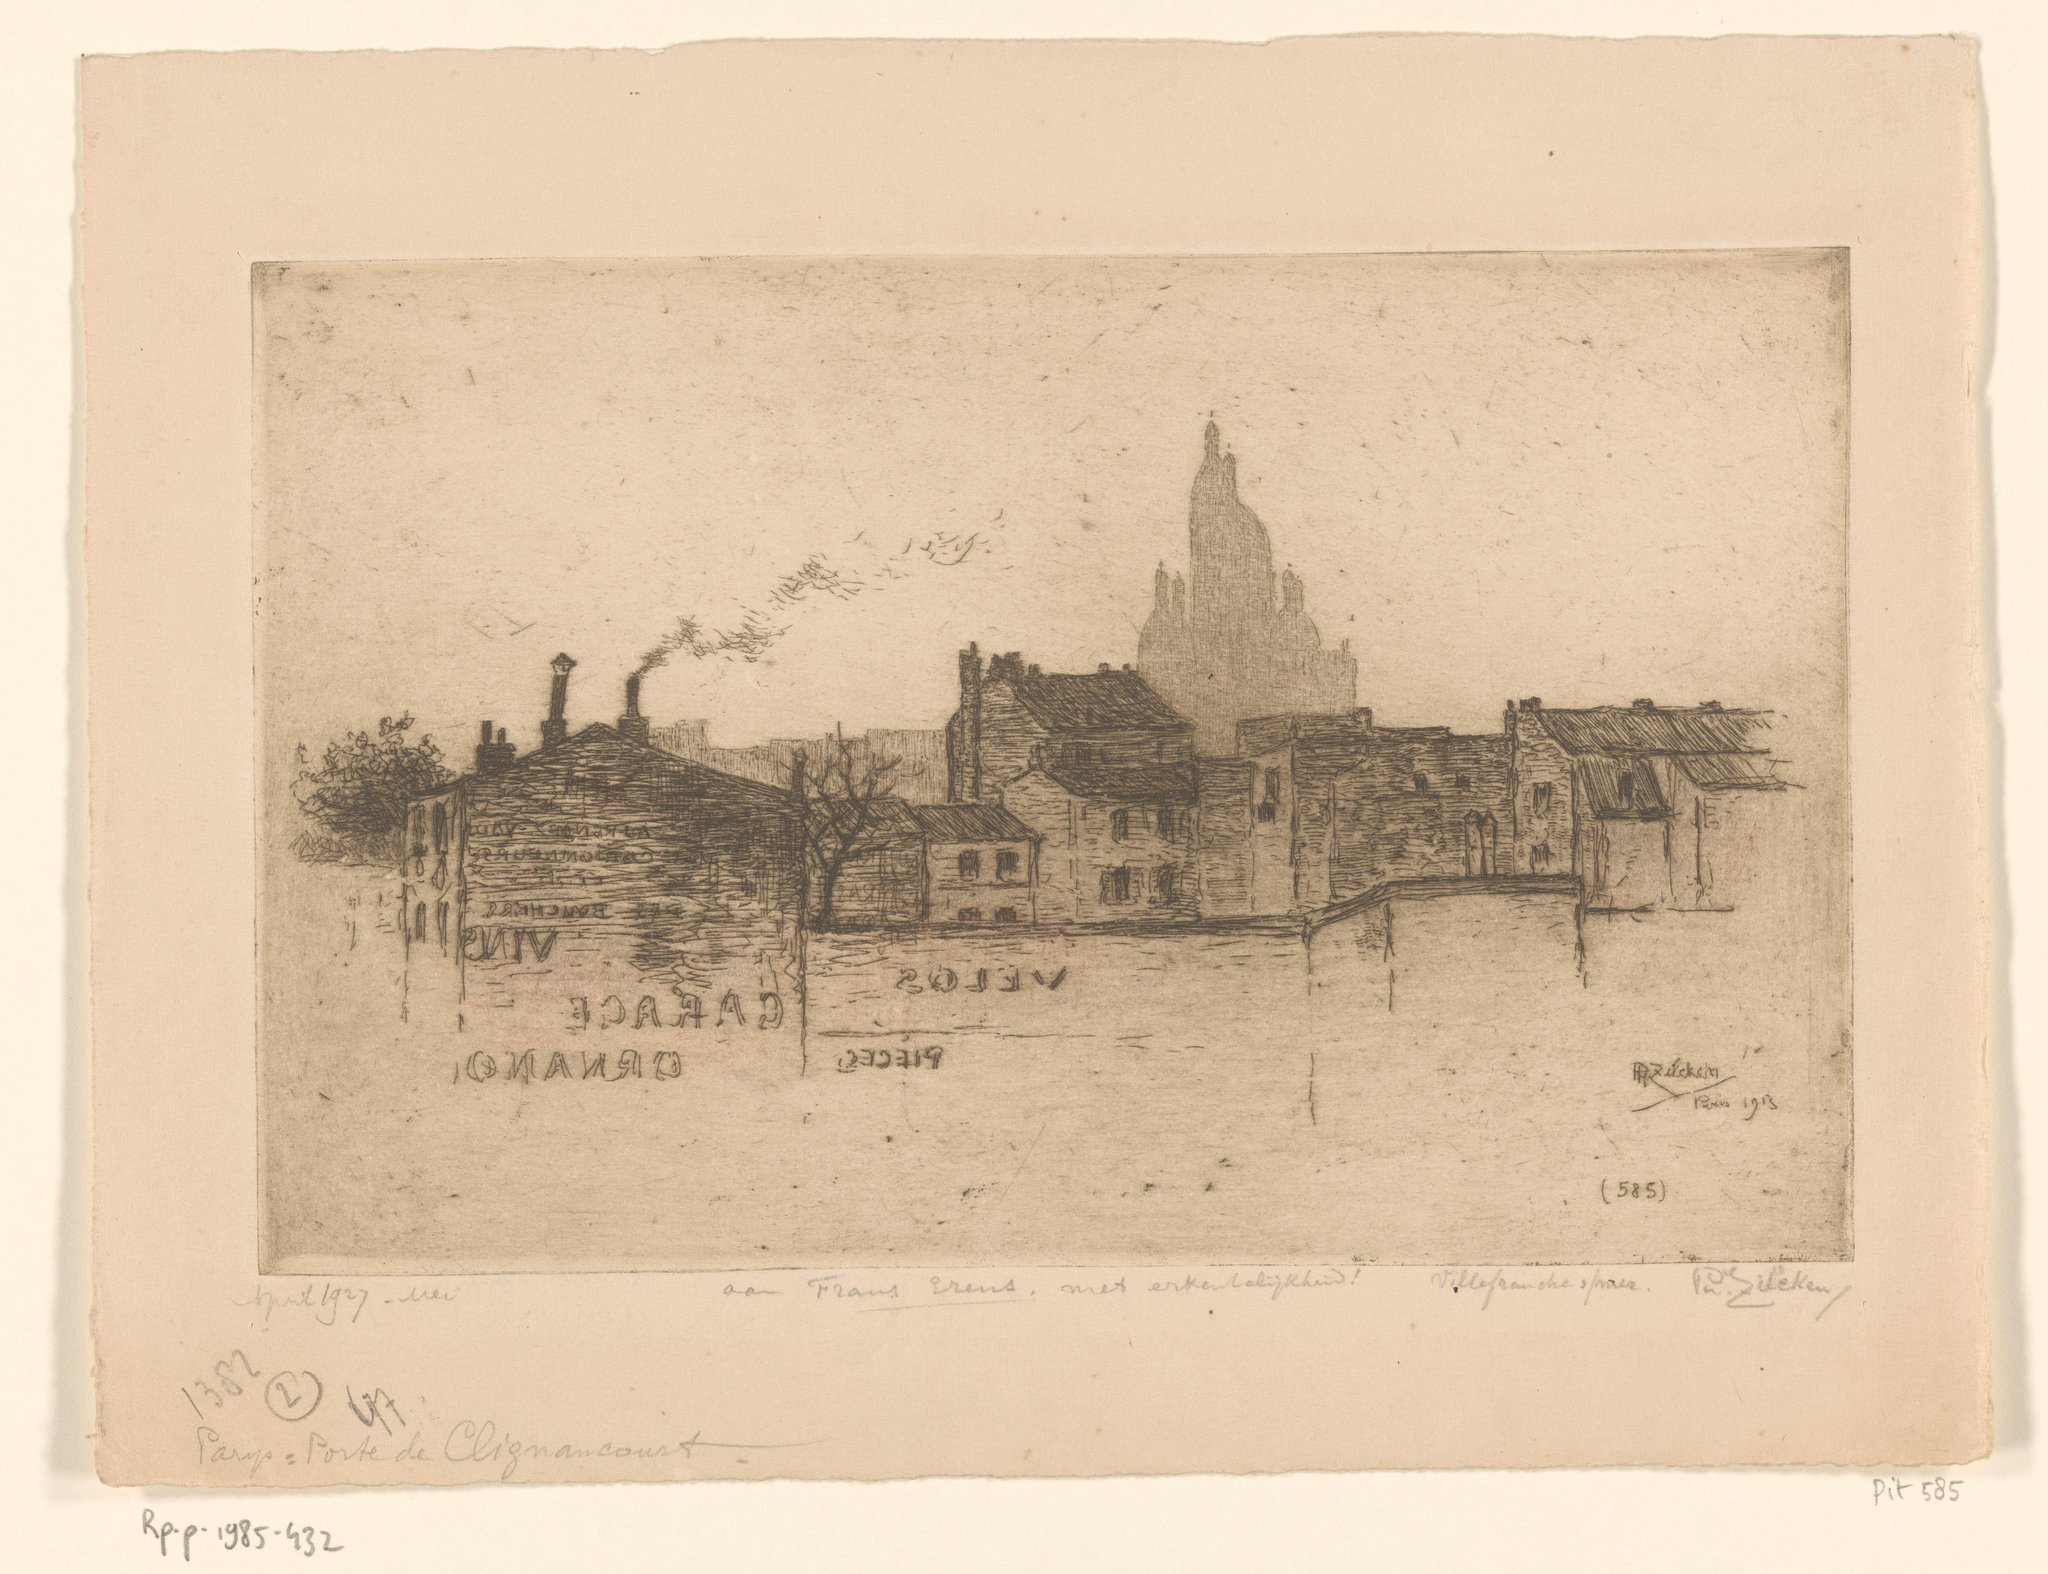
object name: print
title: Près de la Porte Clignancourt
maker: philip zilcken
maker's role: draughtsman, painter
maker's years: 1857-1930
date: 1913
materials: paper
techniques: etching, intaglio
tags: city-view in general; 'veduta'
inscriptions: collector's mark: Lugt 2760, collector's mark: Lugt 2228, annotation: ‘April 1927 - Mei/ Aan Frans grens, met erkentelijkheid!/ Villefranche s/mer’